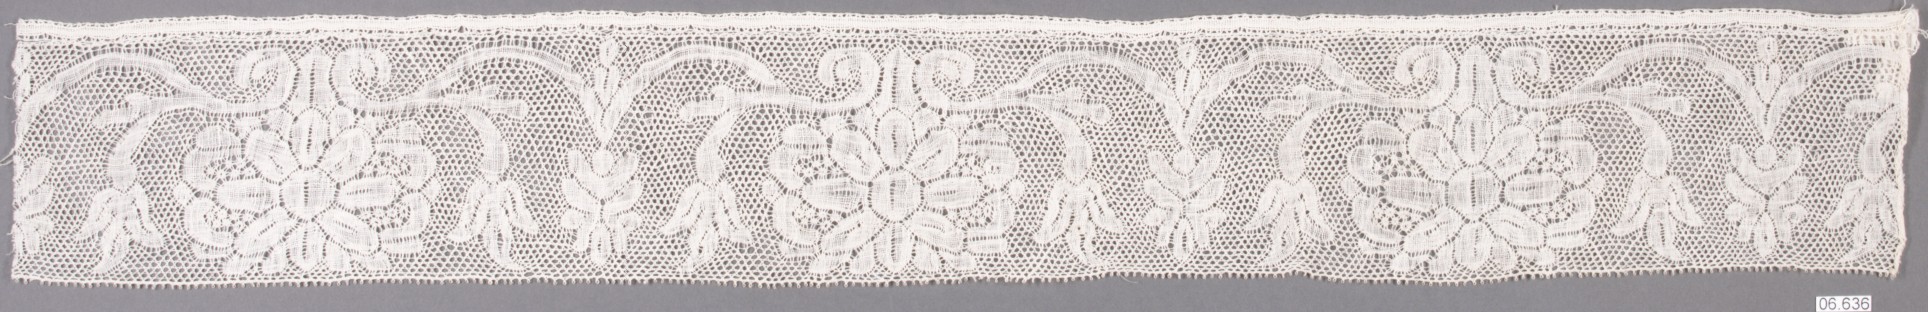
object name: strip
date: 1700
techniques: lace